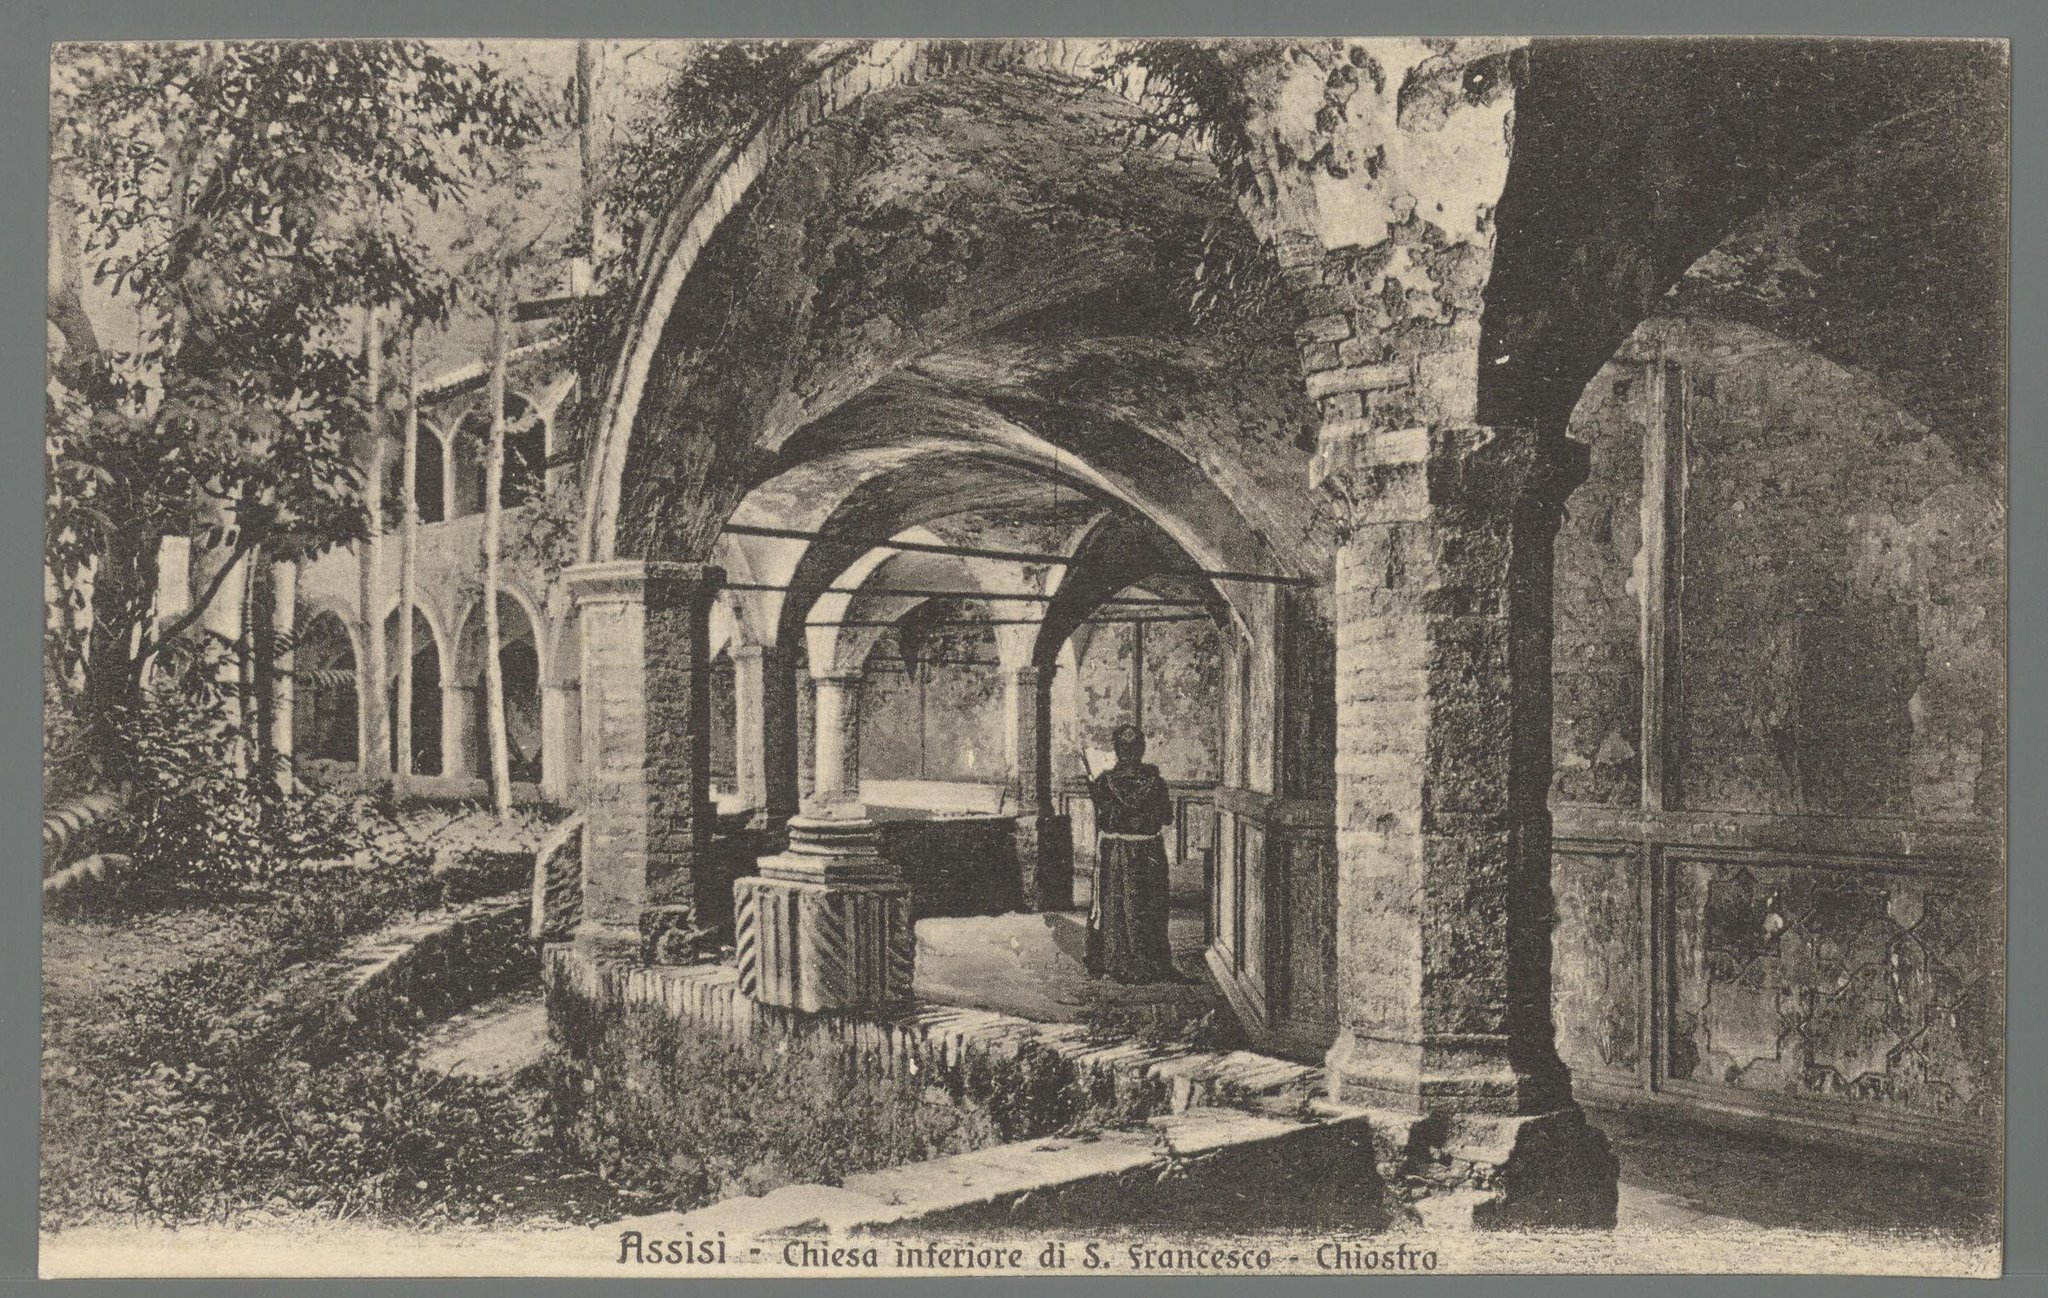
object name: ansichtkaart, prentbriefkaart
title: Assisi - Chiesa inferiore di S. Francesco - Chiostro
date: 1906-1930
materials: cardboard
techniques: photograph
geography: switzerland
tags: abbey, monastery, convent ~ roman catholic church, church (exterior)